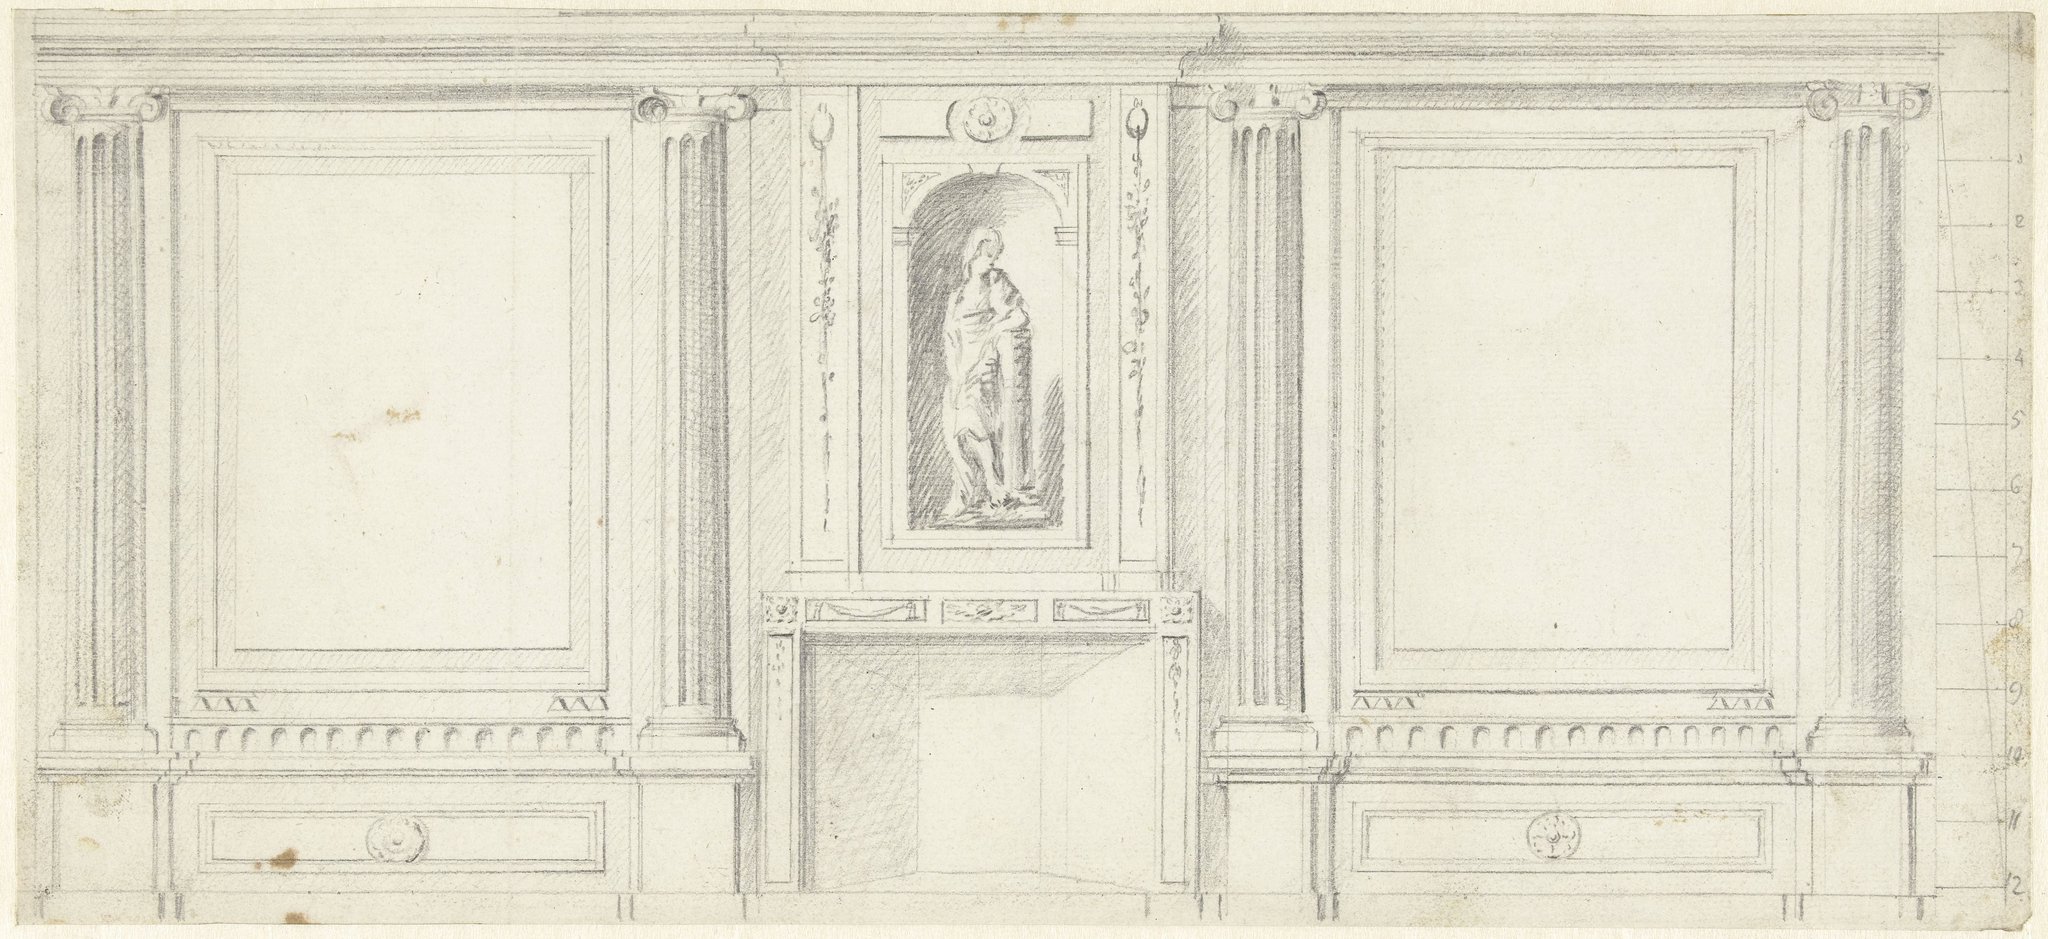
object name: design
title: Ontwerp voor kamerversiering met drie panelen met boven de schoorsteenmantel een staande figuur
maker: abraham meertens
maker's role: draughtsman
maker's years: 1757-1823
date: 1767-1823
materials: paper, pencil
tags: wall-covering